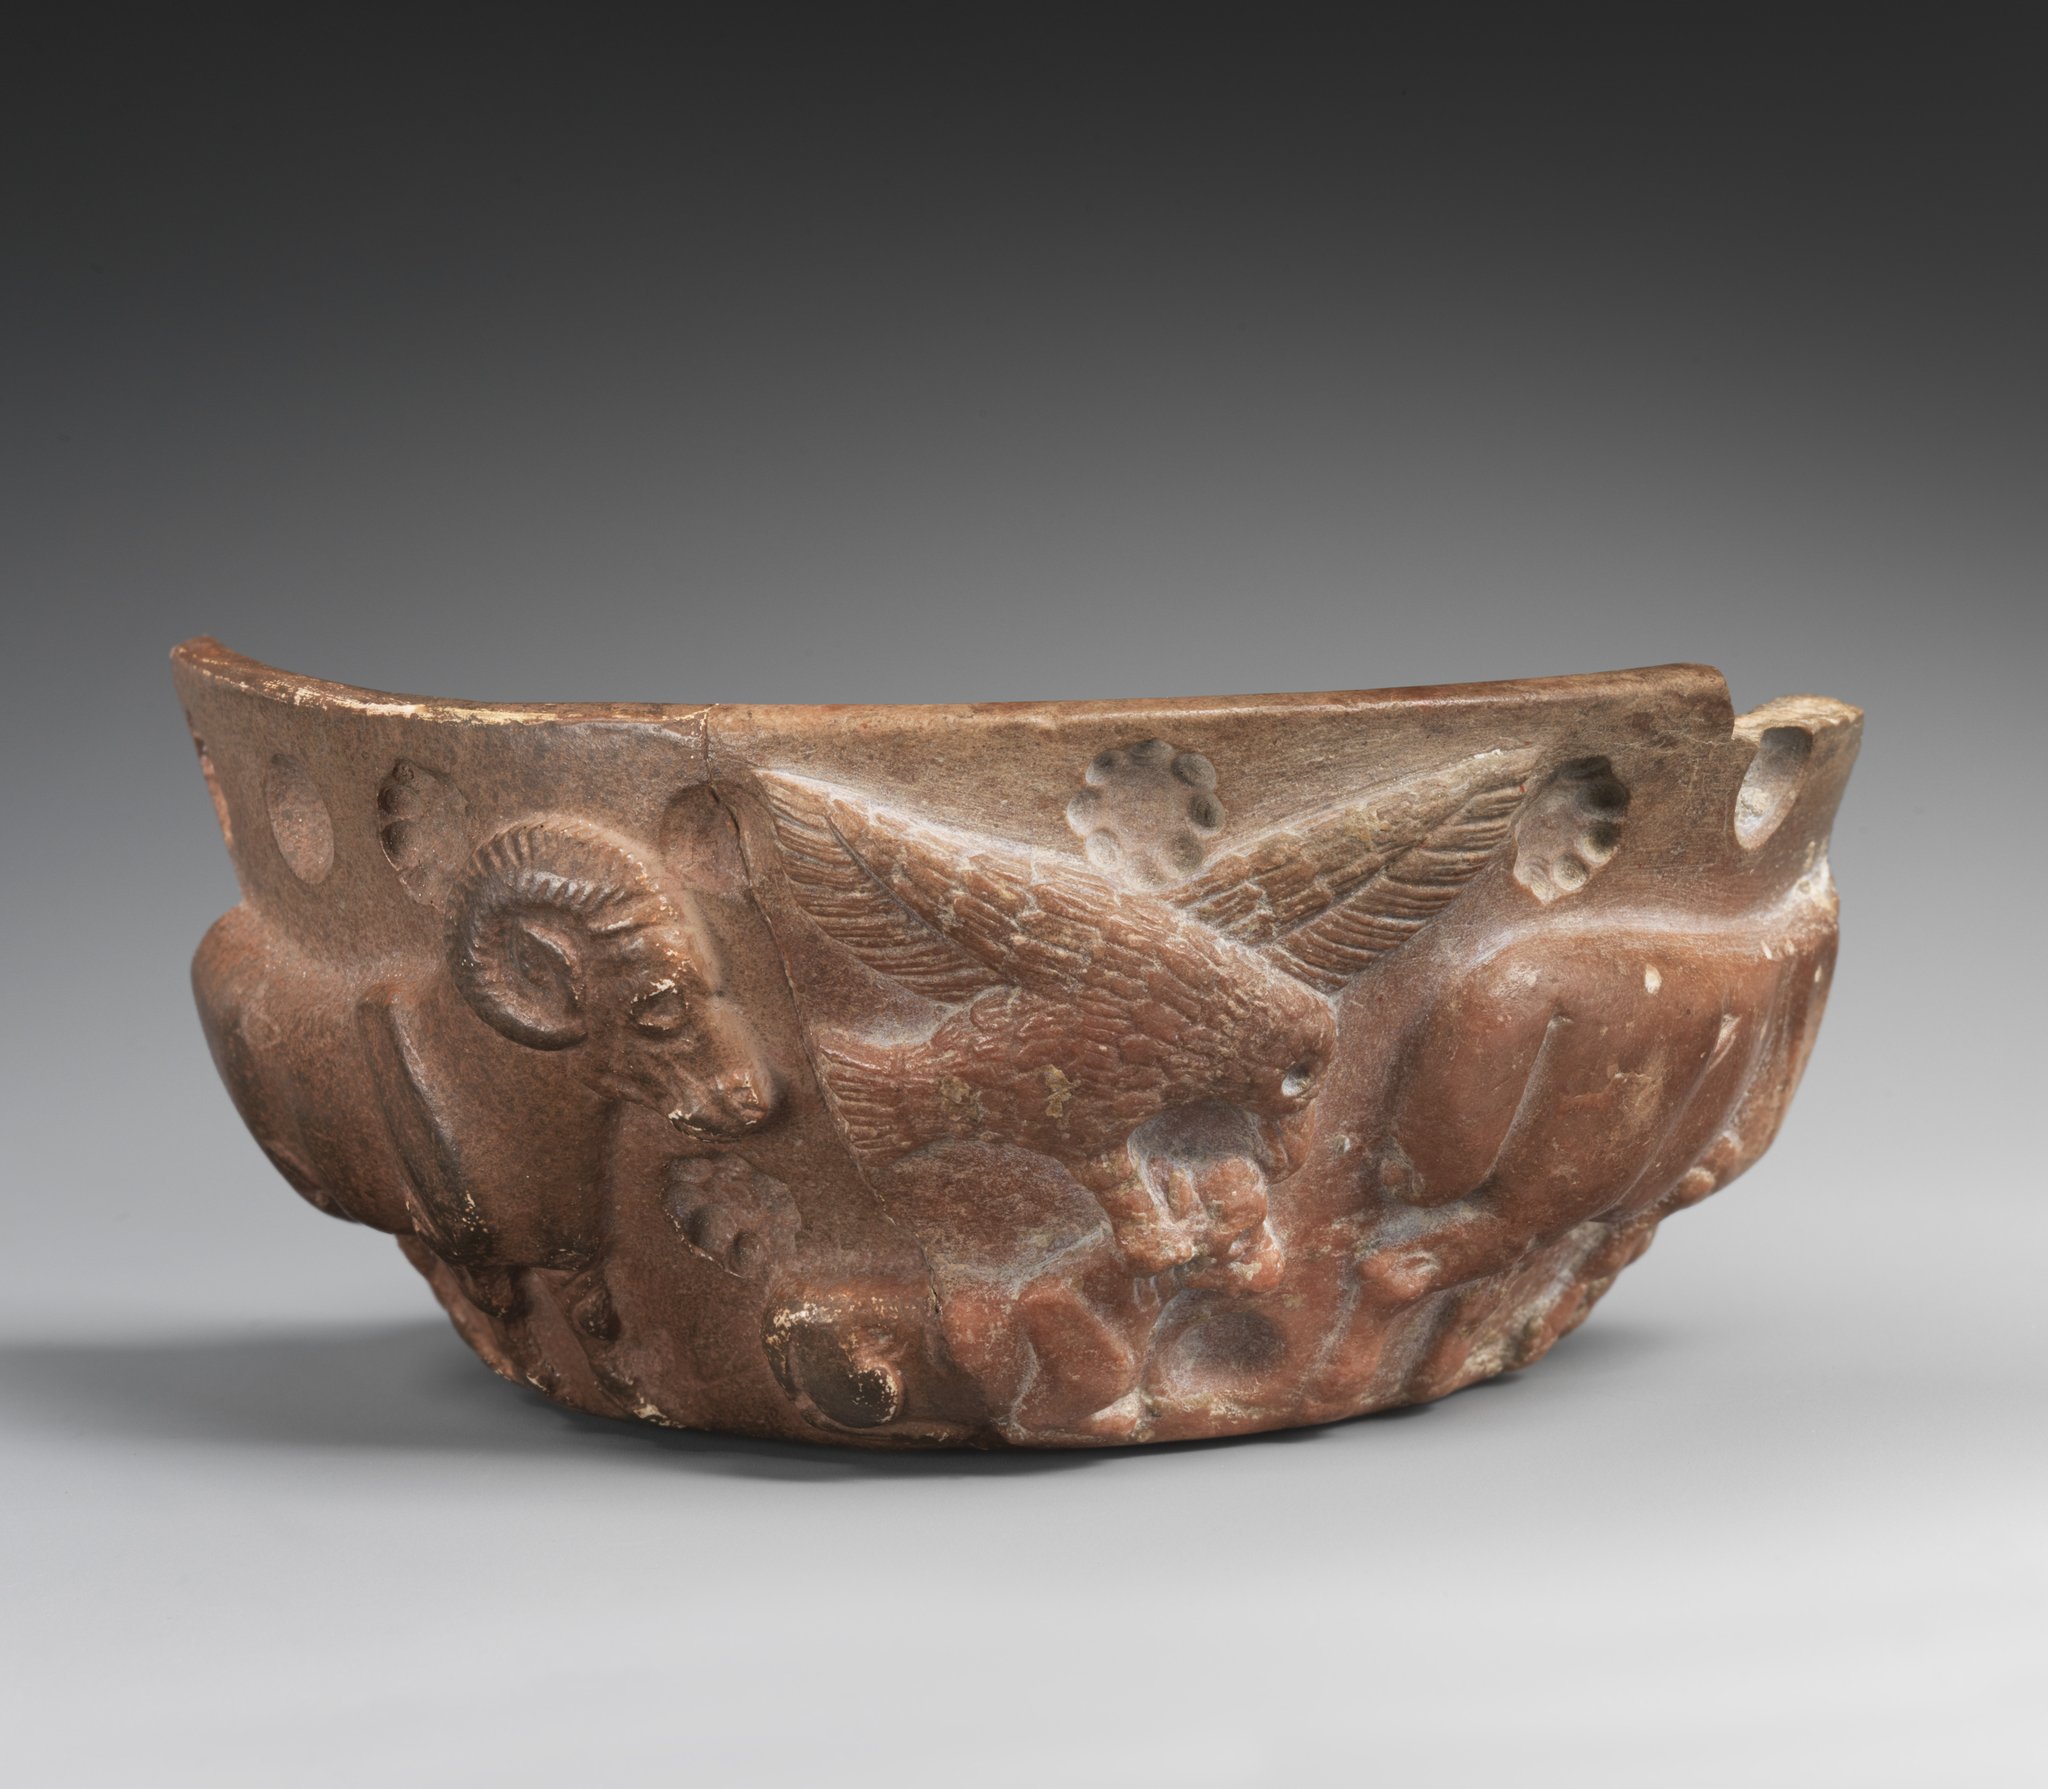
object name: vessel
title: Fragment of a vessel with animals in relief, joined to a cast of another fragment from the same bowl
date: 3300-2900 BCE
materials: limestone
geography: southern mesopotamia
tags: animals,birds